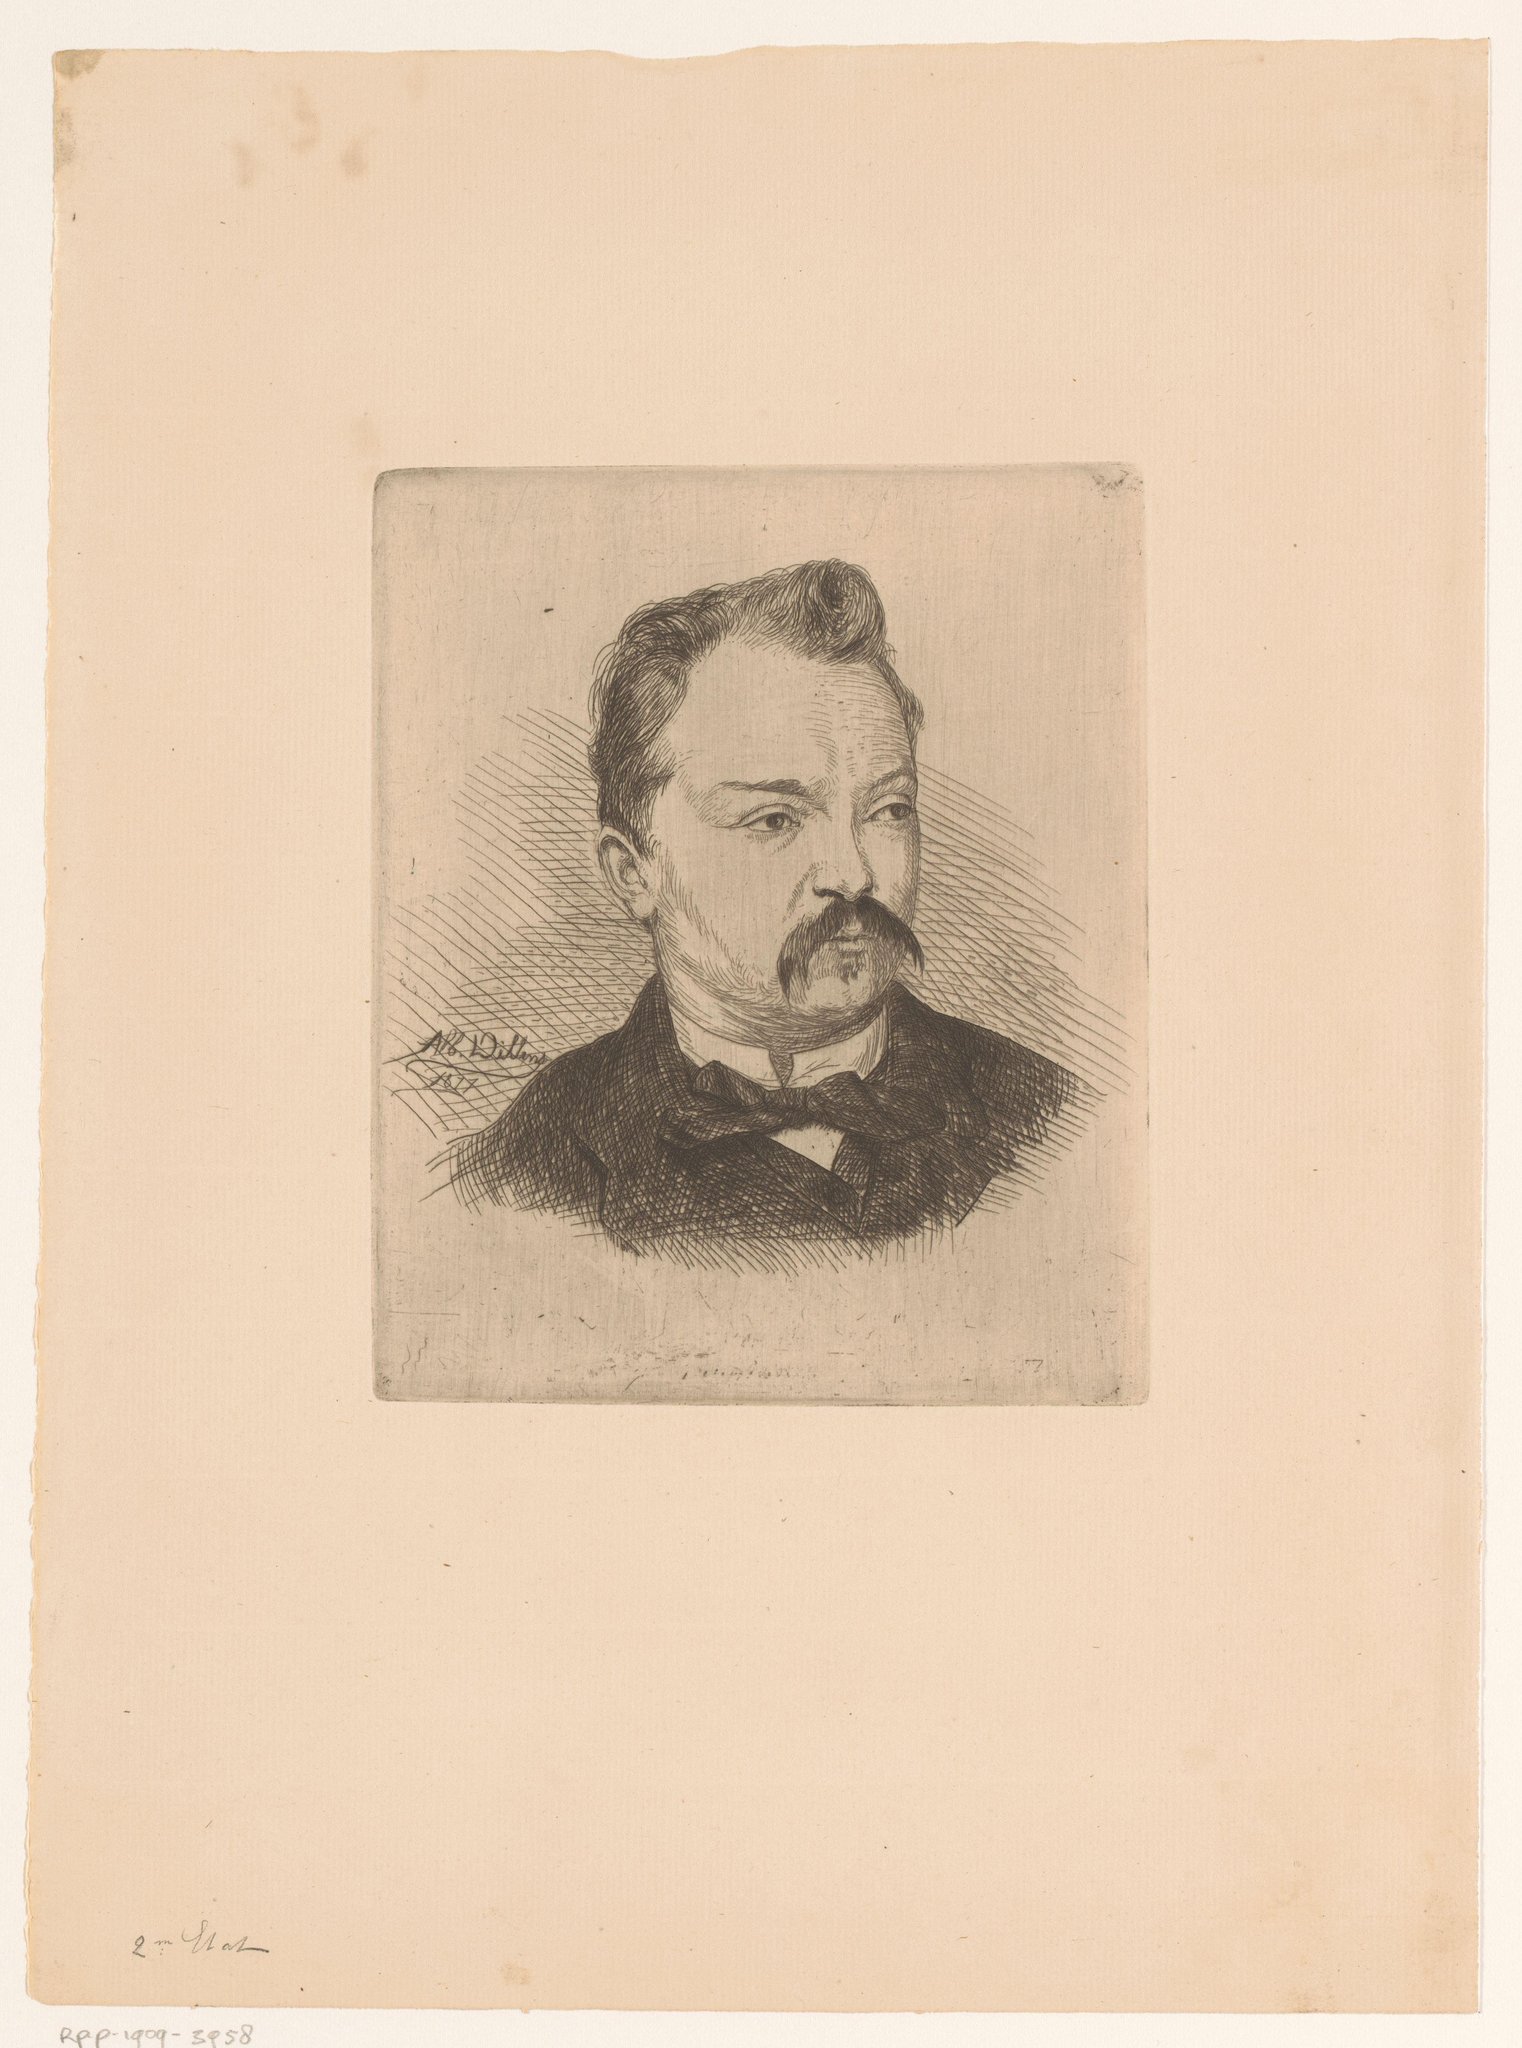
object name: print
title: Portret van een onbekende man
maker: albert dillens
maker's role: print maker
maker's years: 1844-1915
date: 1877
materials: paper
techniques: etching, intaglio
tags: adult man, historical persons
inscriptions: collector's mark: Lugt 2228, inscription: ‘2m Etat’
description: Mogelijk gaat het om een kamerlid genaamd Janson.